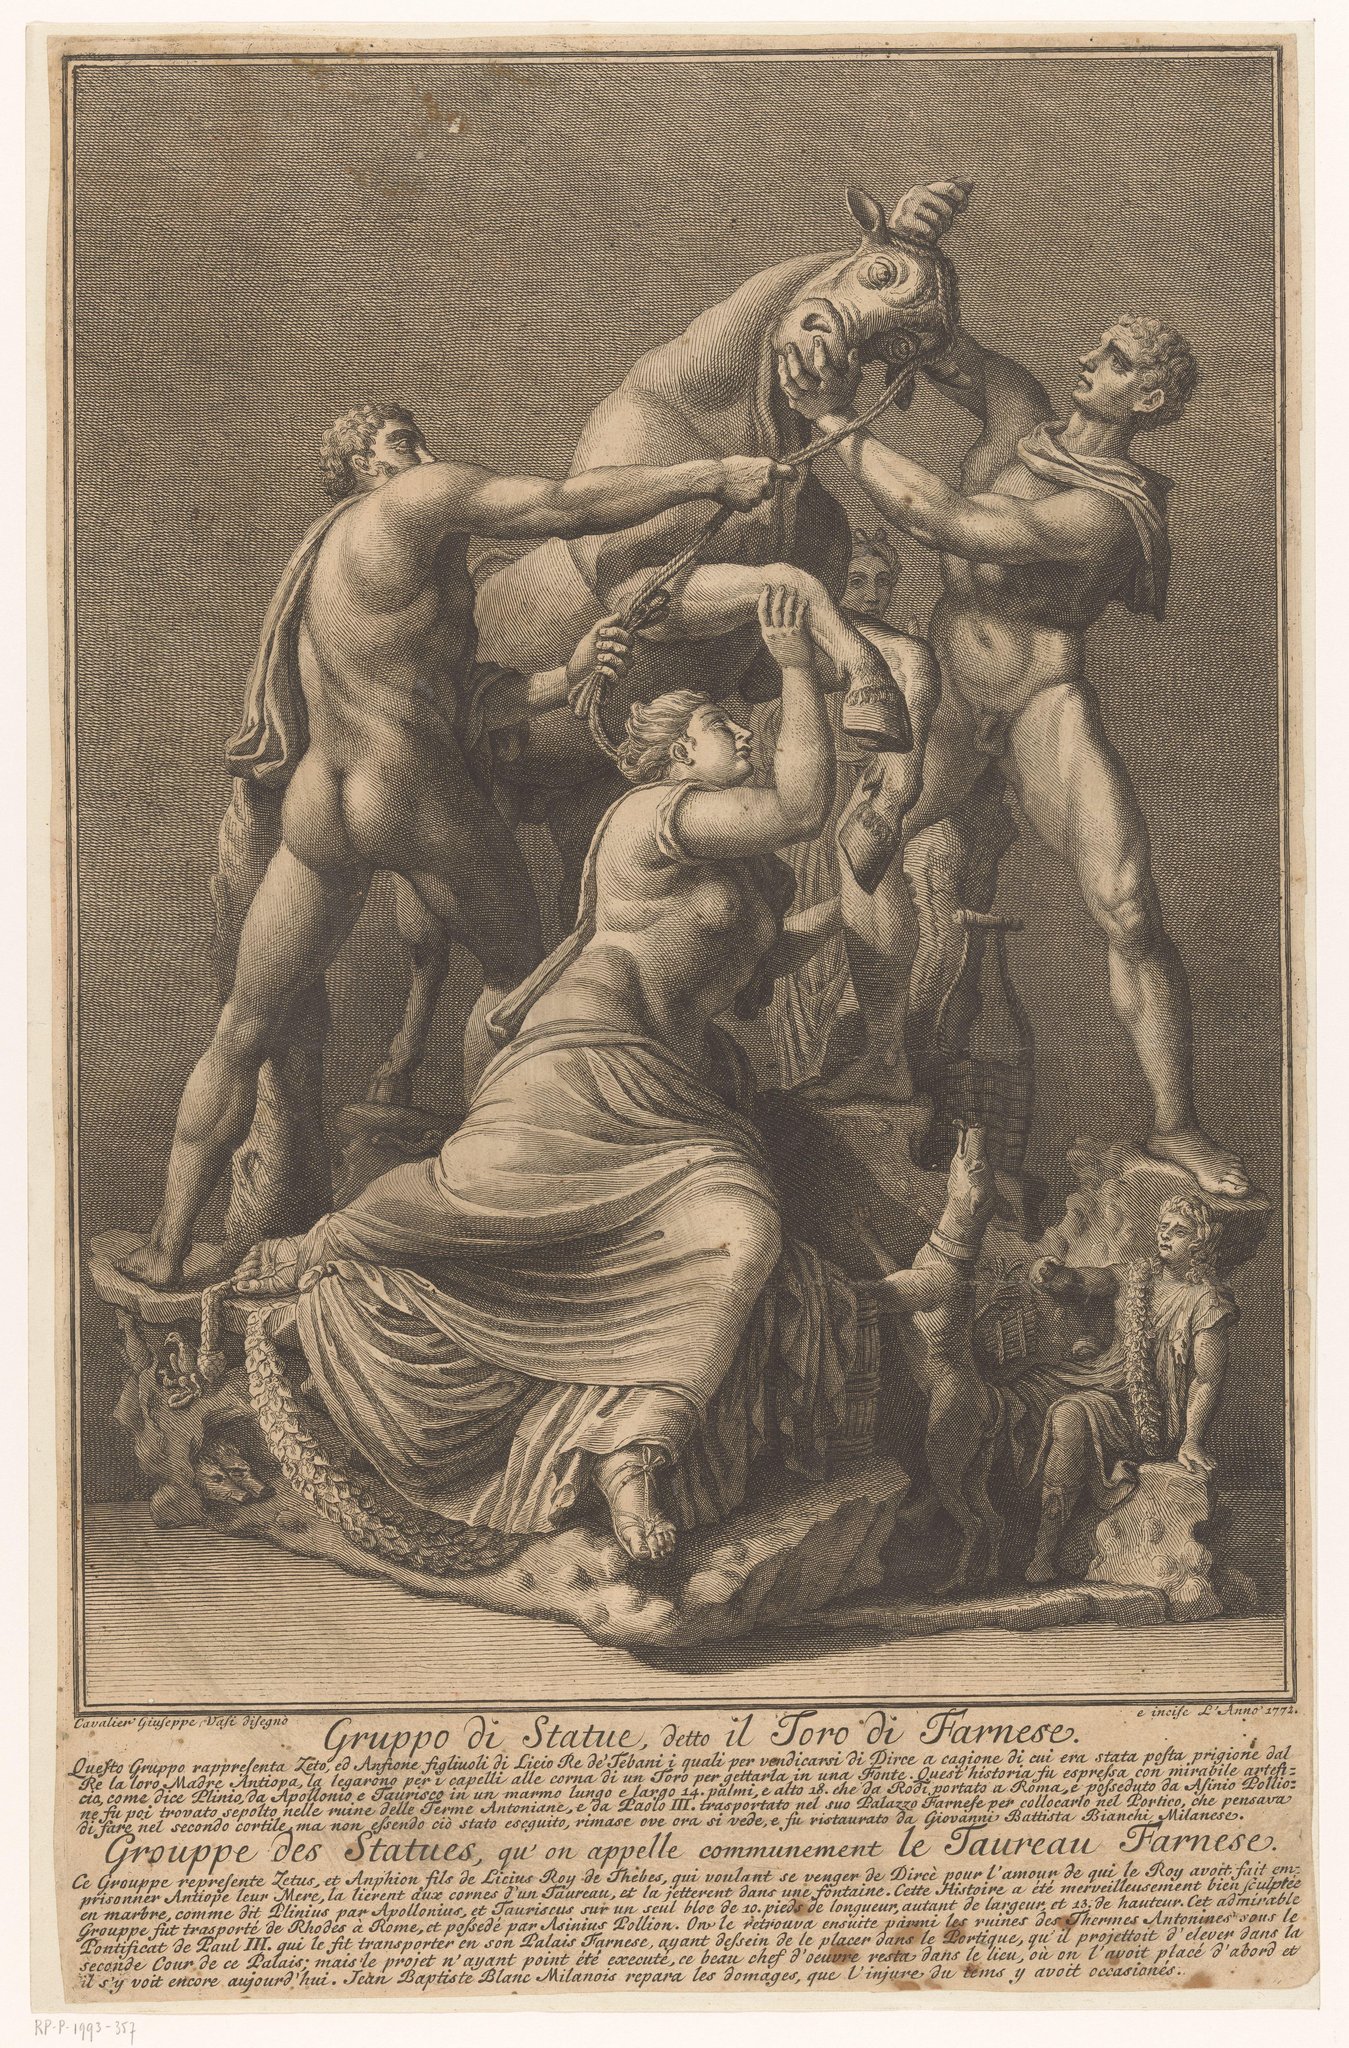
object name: print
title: Gruppo di Statue, detto il Toro di Farnese / Grouppe des Statues, qu' on appelle communement le Taureau Farnese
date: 1772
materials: paper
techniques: etching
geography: italy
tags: piece of sculpture, reproduction of a piece of sculpture, amphion and zethus avenge their mother by tying dirce to the horns of a bull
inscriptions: collector's mark: Lugt 2228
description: Antieke sculptuur bekend als de Farnese Stier. De broers Amphion en Zethus binden de gevlochten haren van Dirce vast aan de hoorns van een stier. In ondermarge titels, vijfregelige Italiaanse tekst en zevenregelige Franse tekst.